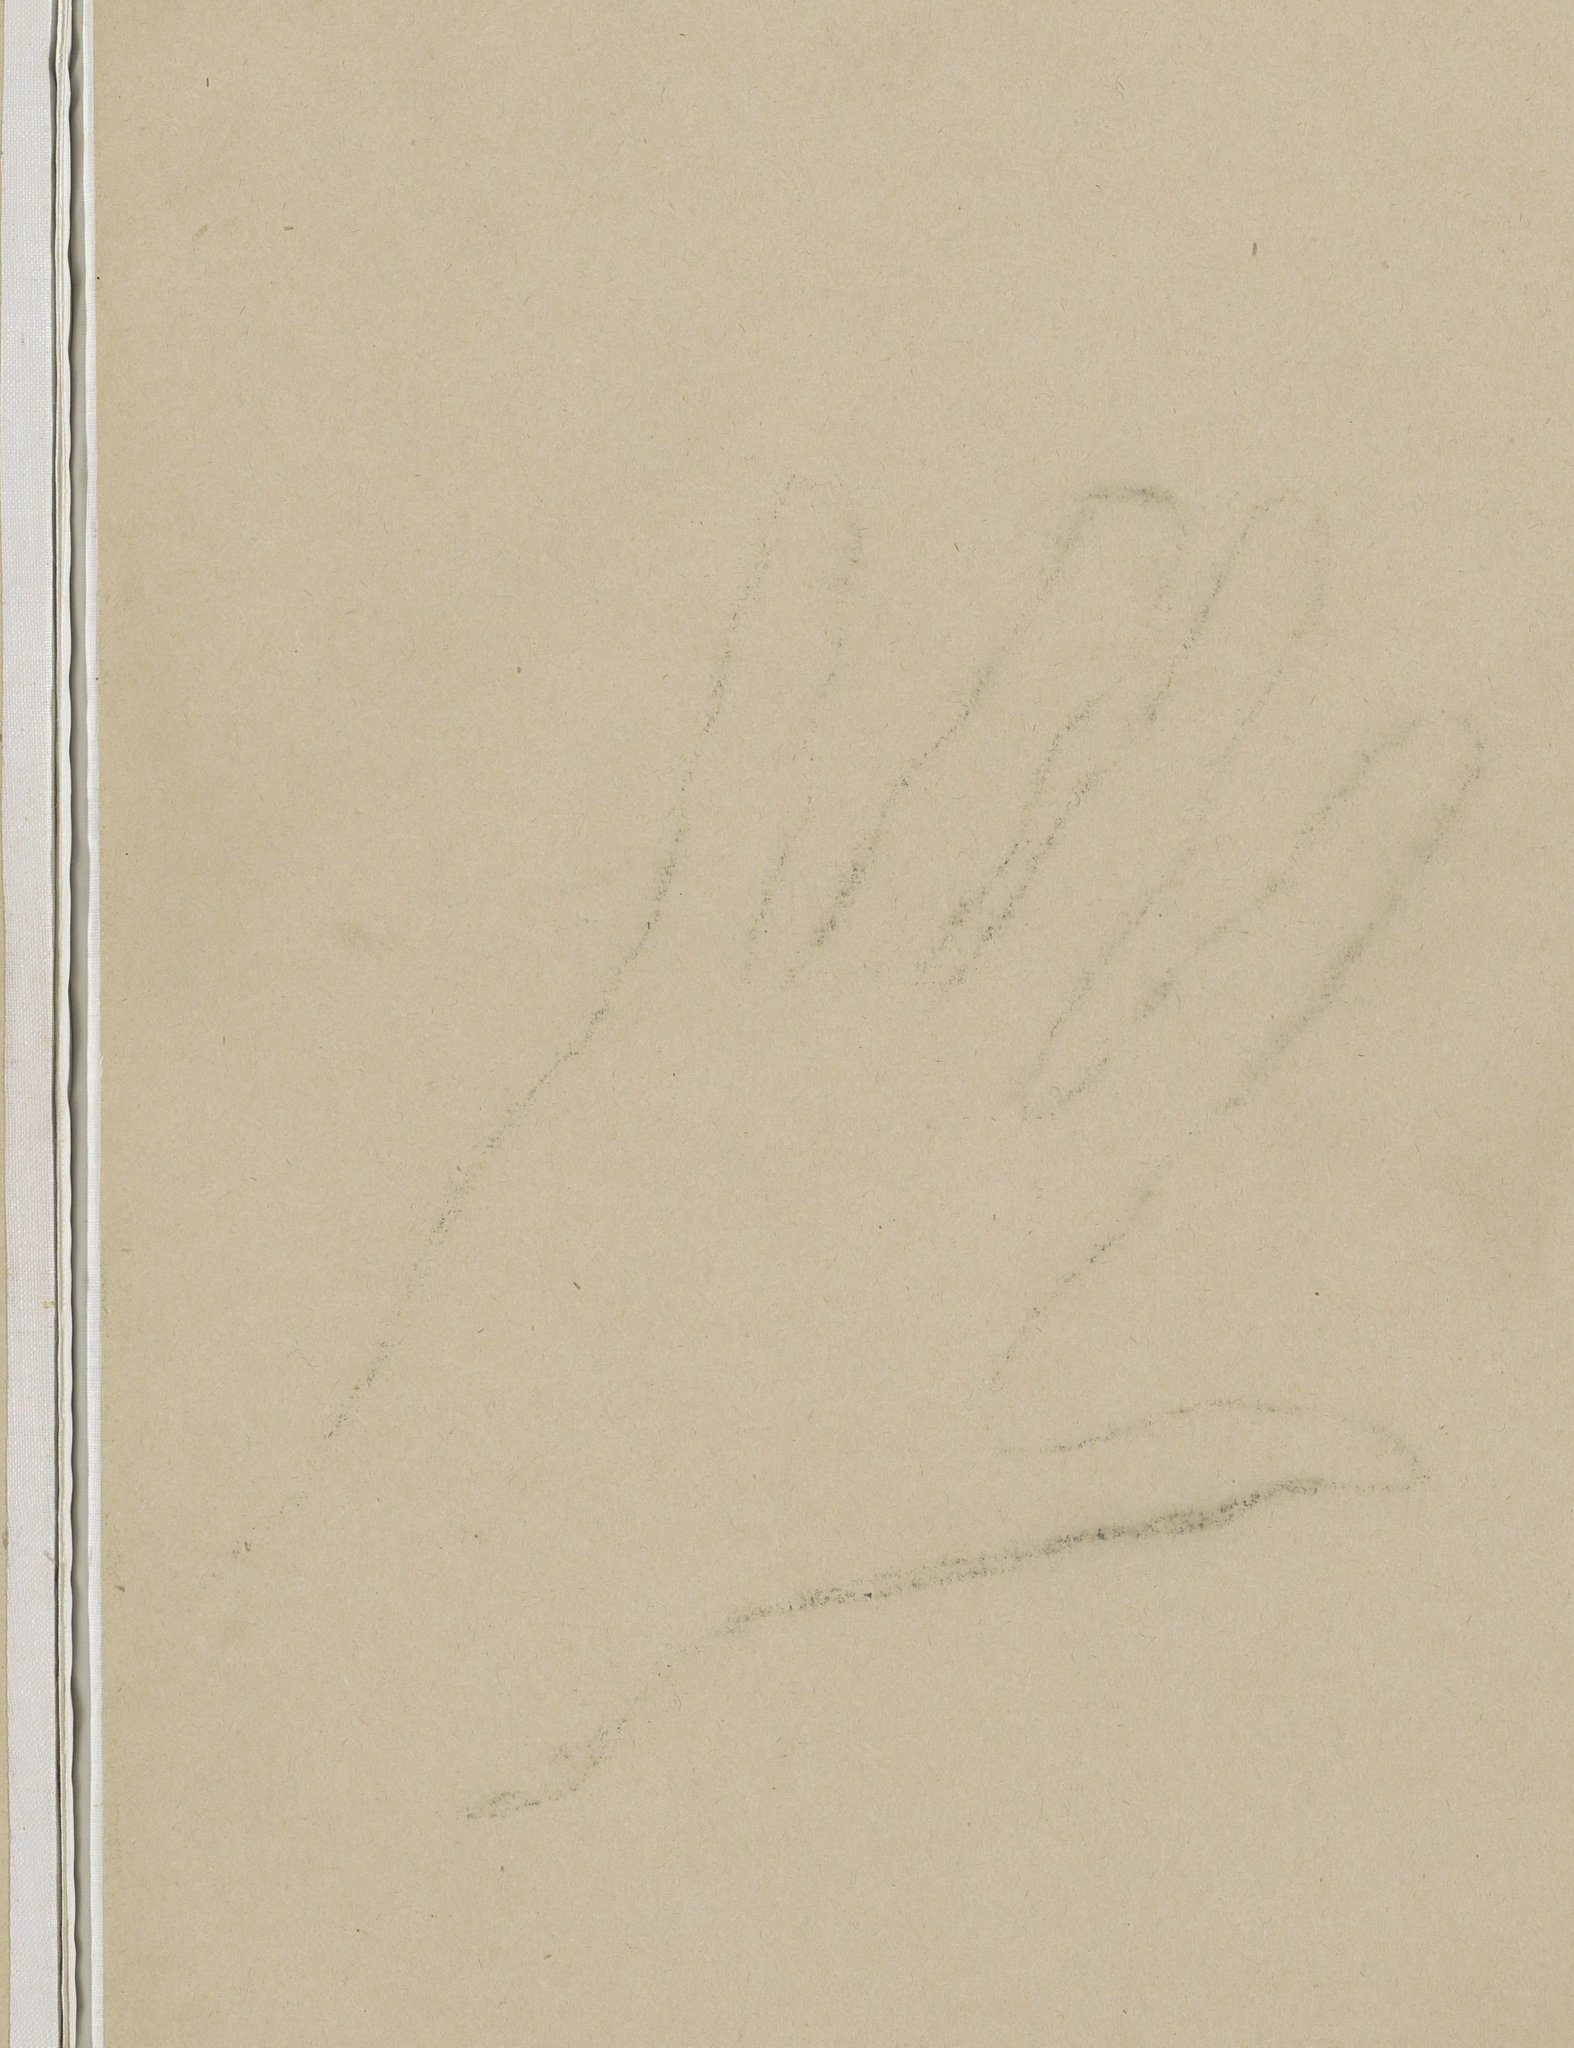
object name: sketchbook leaf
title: Abklatsch van de krijttekening op pagina 42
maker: willem witsen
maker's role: draughtsman, painter, print maker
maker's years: 1860-1923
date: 1874-1923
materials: paper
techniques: printmaking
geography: ewijkshoeve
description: Pagina 43 uit een schetsboek met 72 bladen.